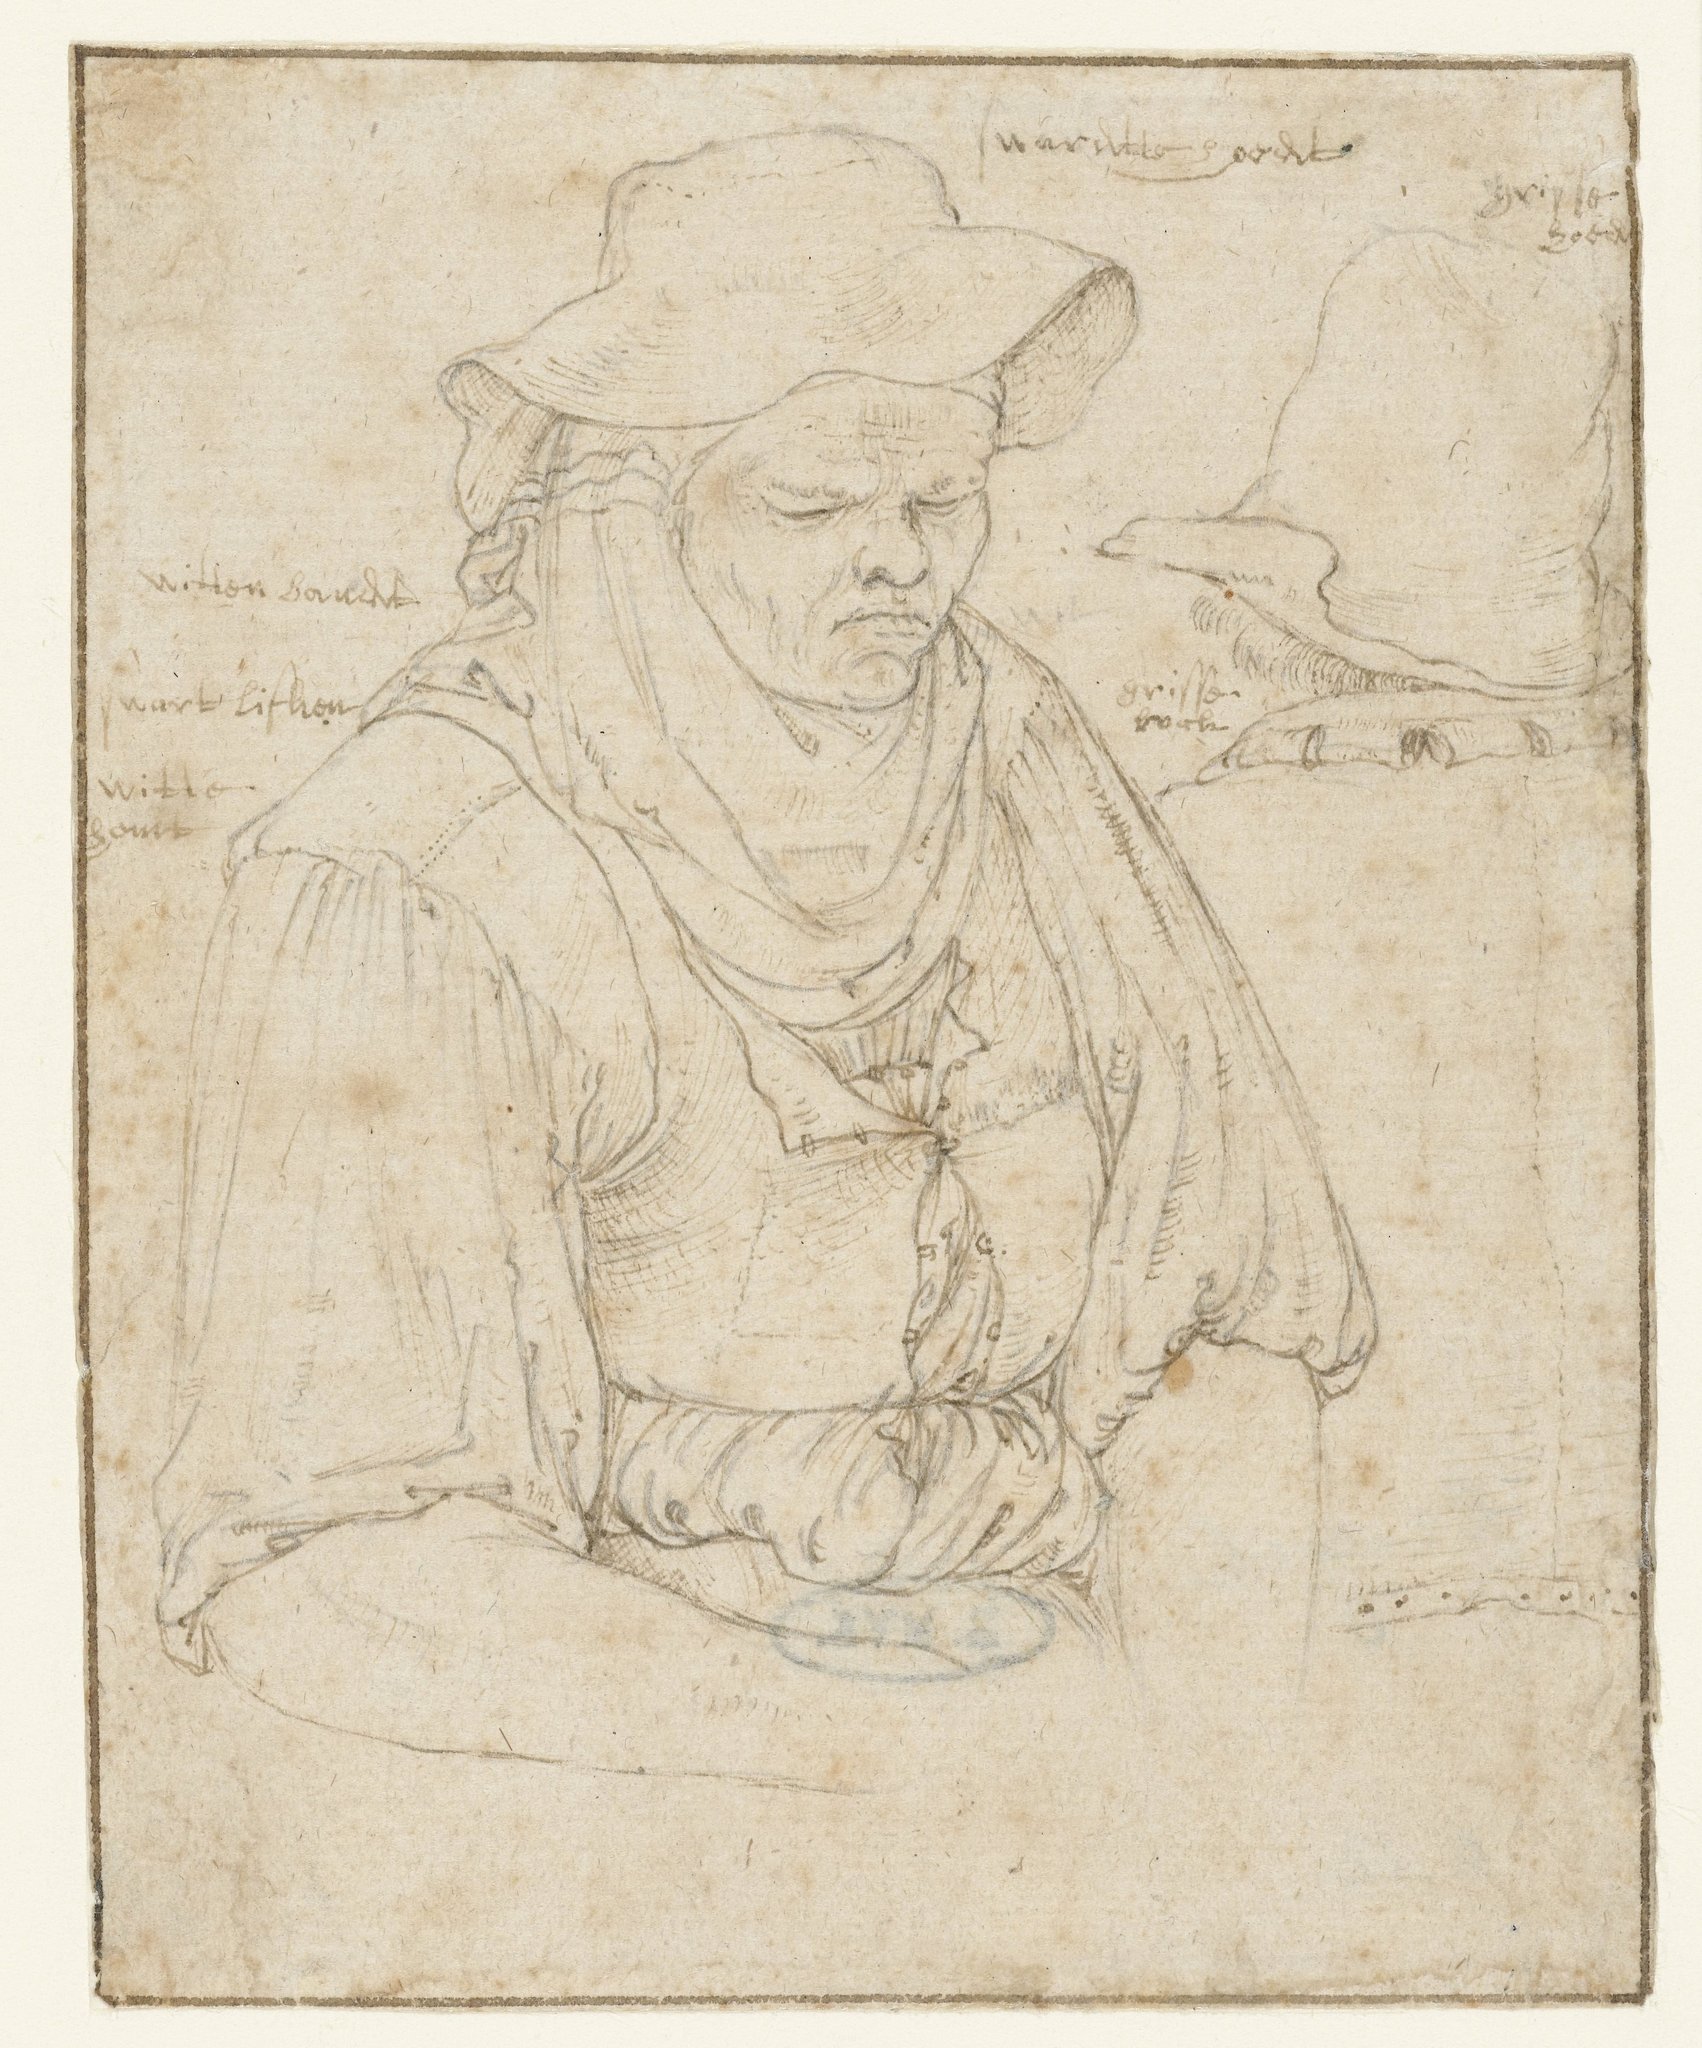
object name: drawing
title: Oude vrouw en een man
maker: roelant savery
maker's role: draughtsman, painter, print maker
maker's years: 1576-1639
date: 1603-1613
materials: chalk, graphite, ink, paper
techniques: pen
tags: sitting figure - aa - female human figure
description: Oude vrouw ten halven lijve, recht van voren, en een man op de rug gezien.